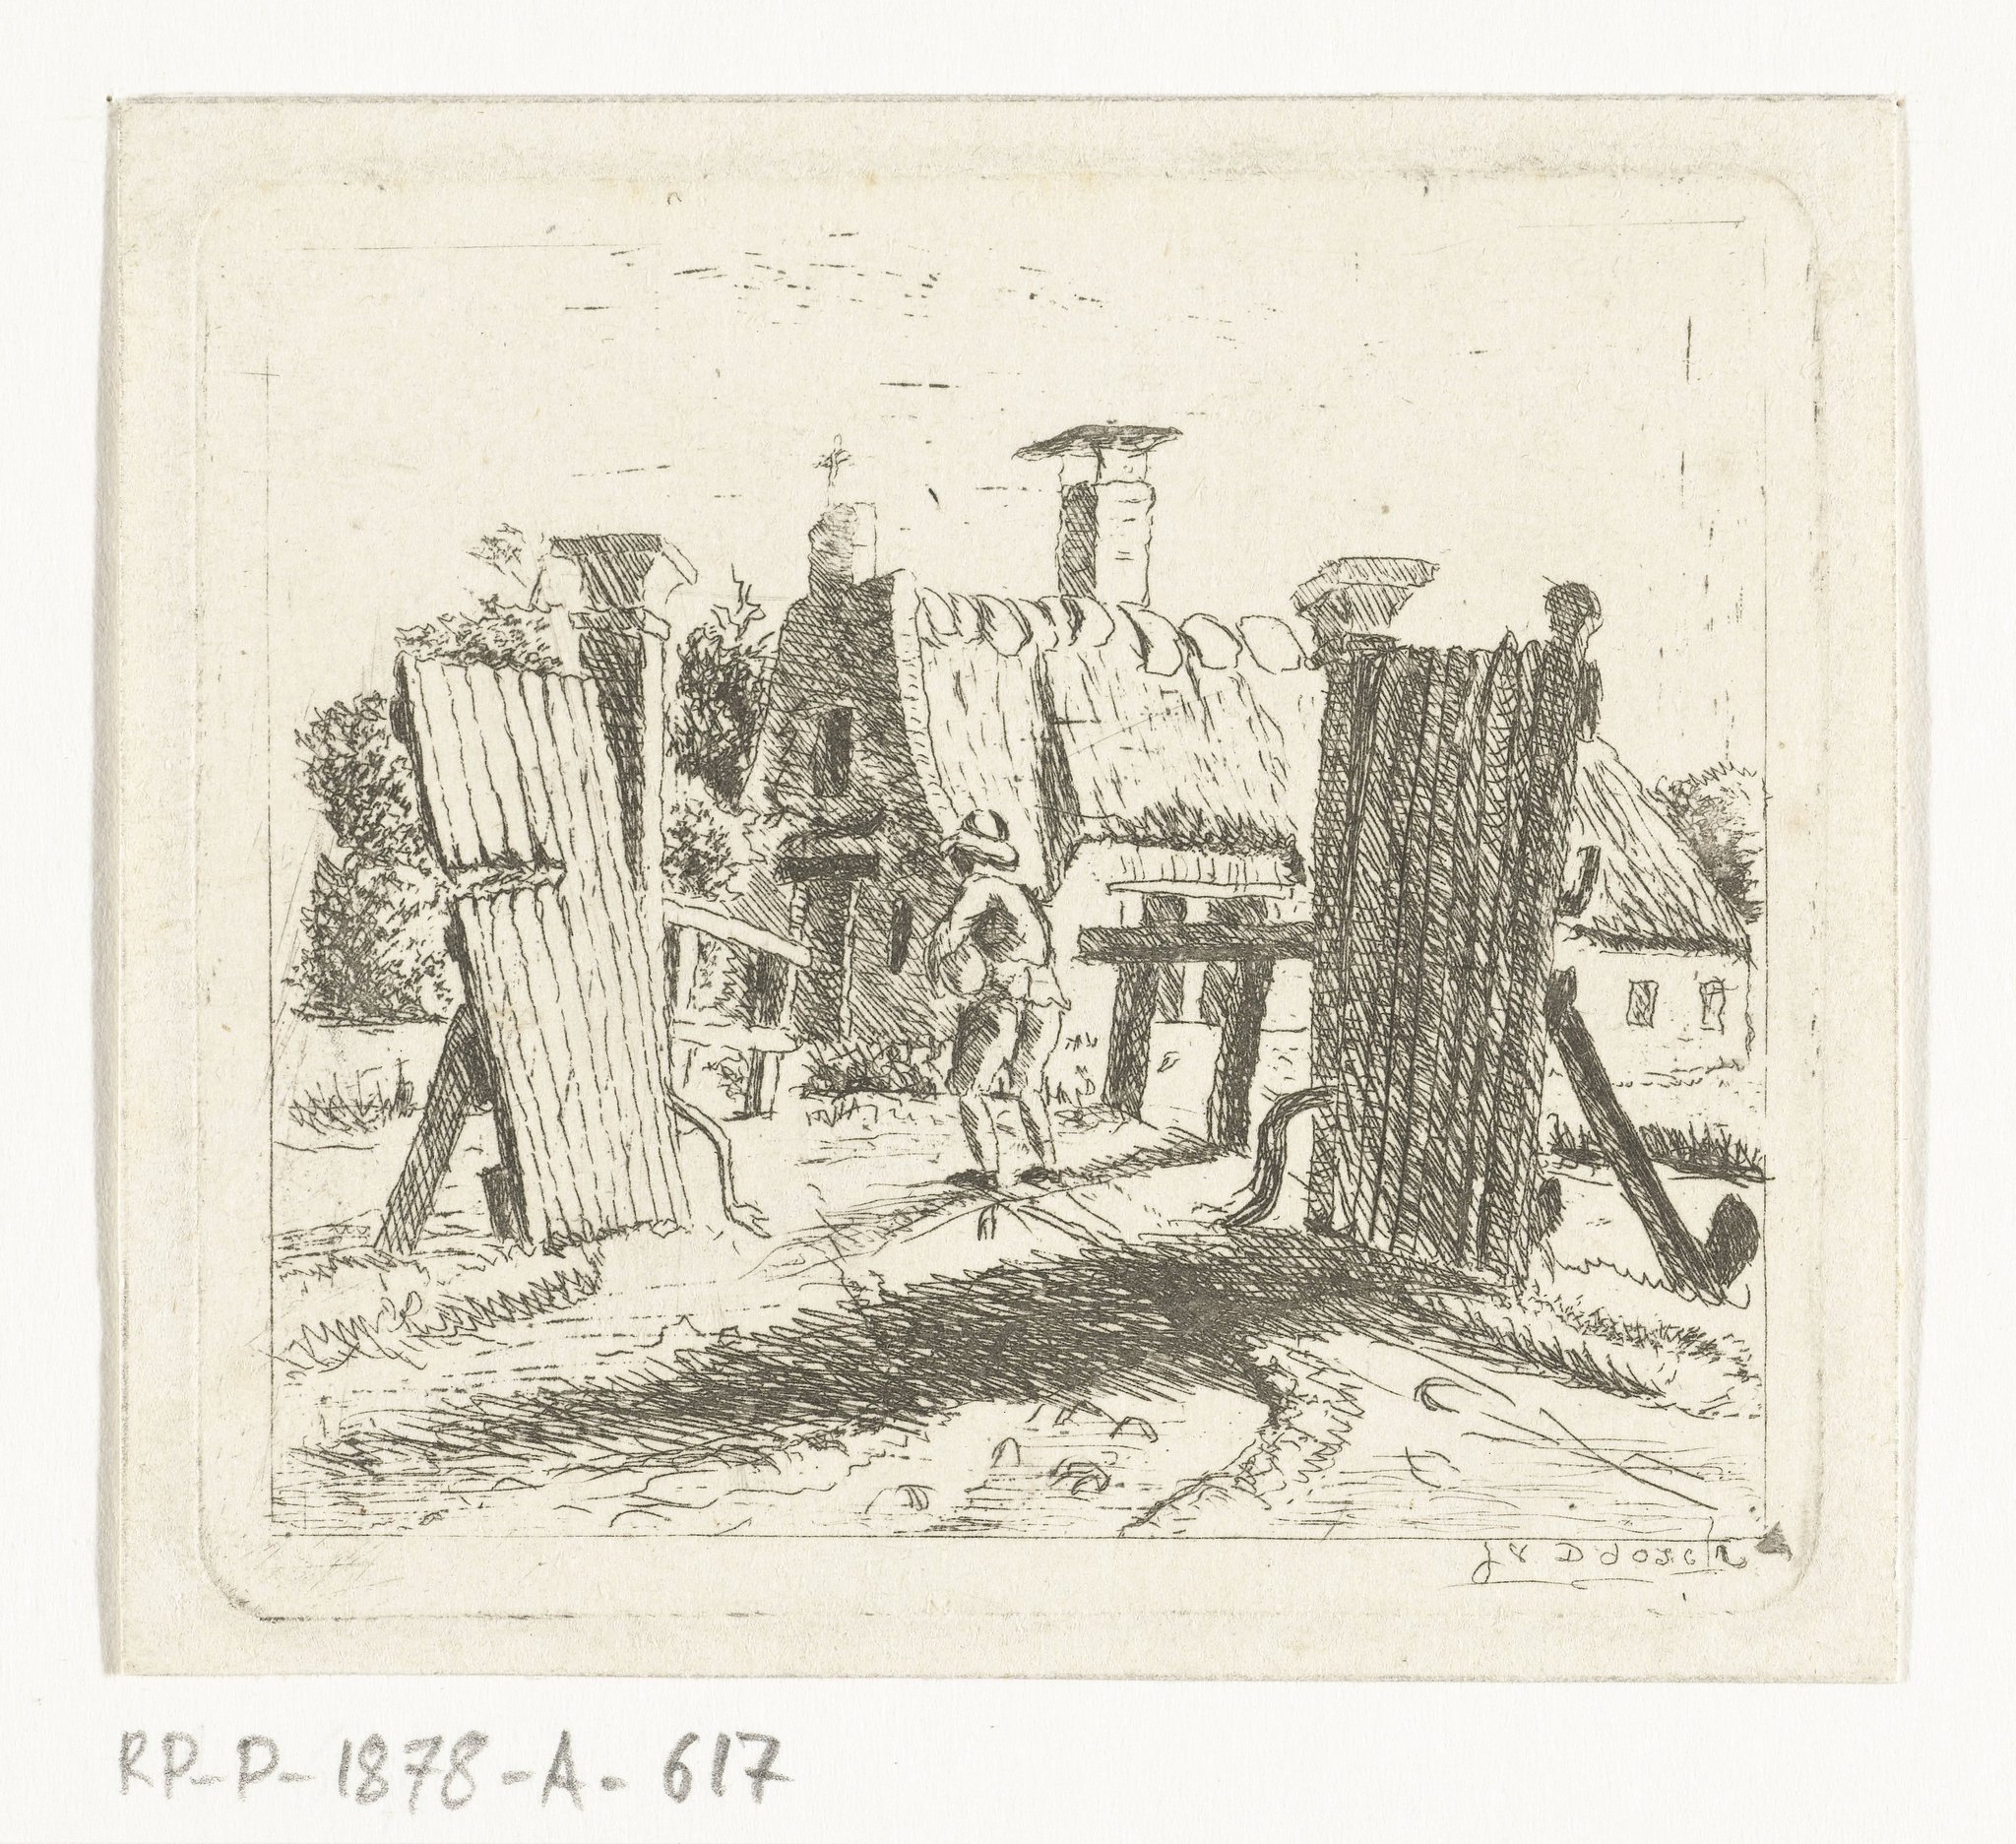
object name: print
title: Man op weg naar een huis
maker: johannes ludovicus van den bos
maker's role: draughtsman, print maker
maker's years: 1800-1827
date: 1815-1827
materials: paper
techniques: etching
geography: amsterdam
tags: bridge in village across river, canal, etc.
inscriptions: collector's mark: Lugt 2227